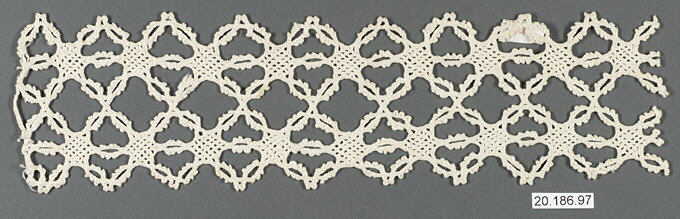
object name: insertion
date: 1501-1600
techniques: lace